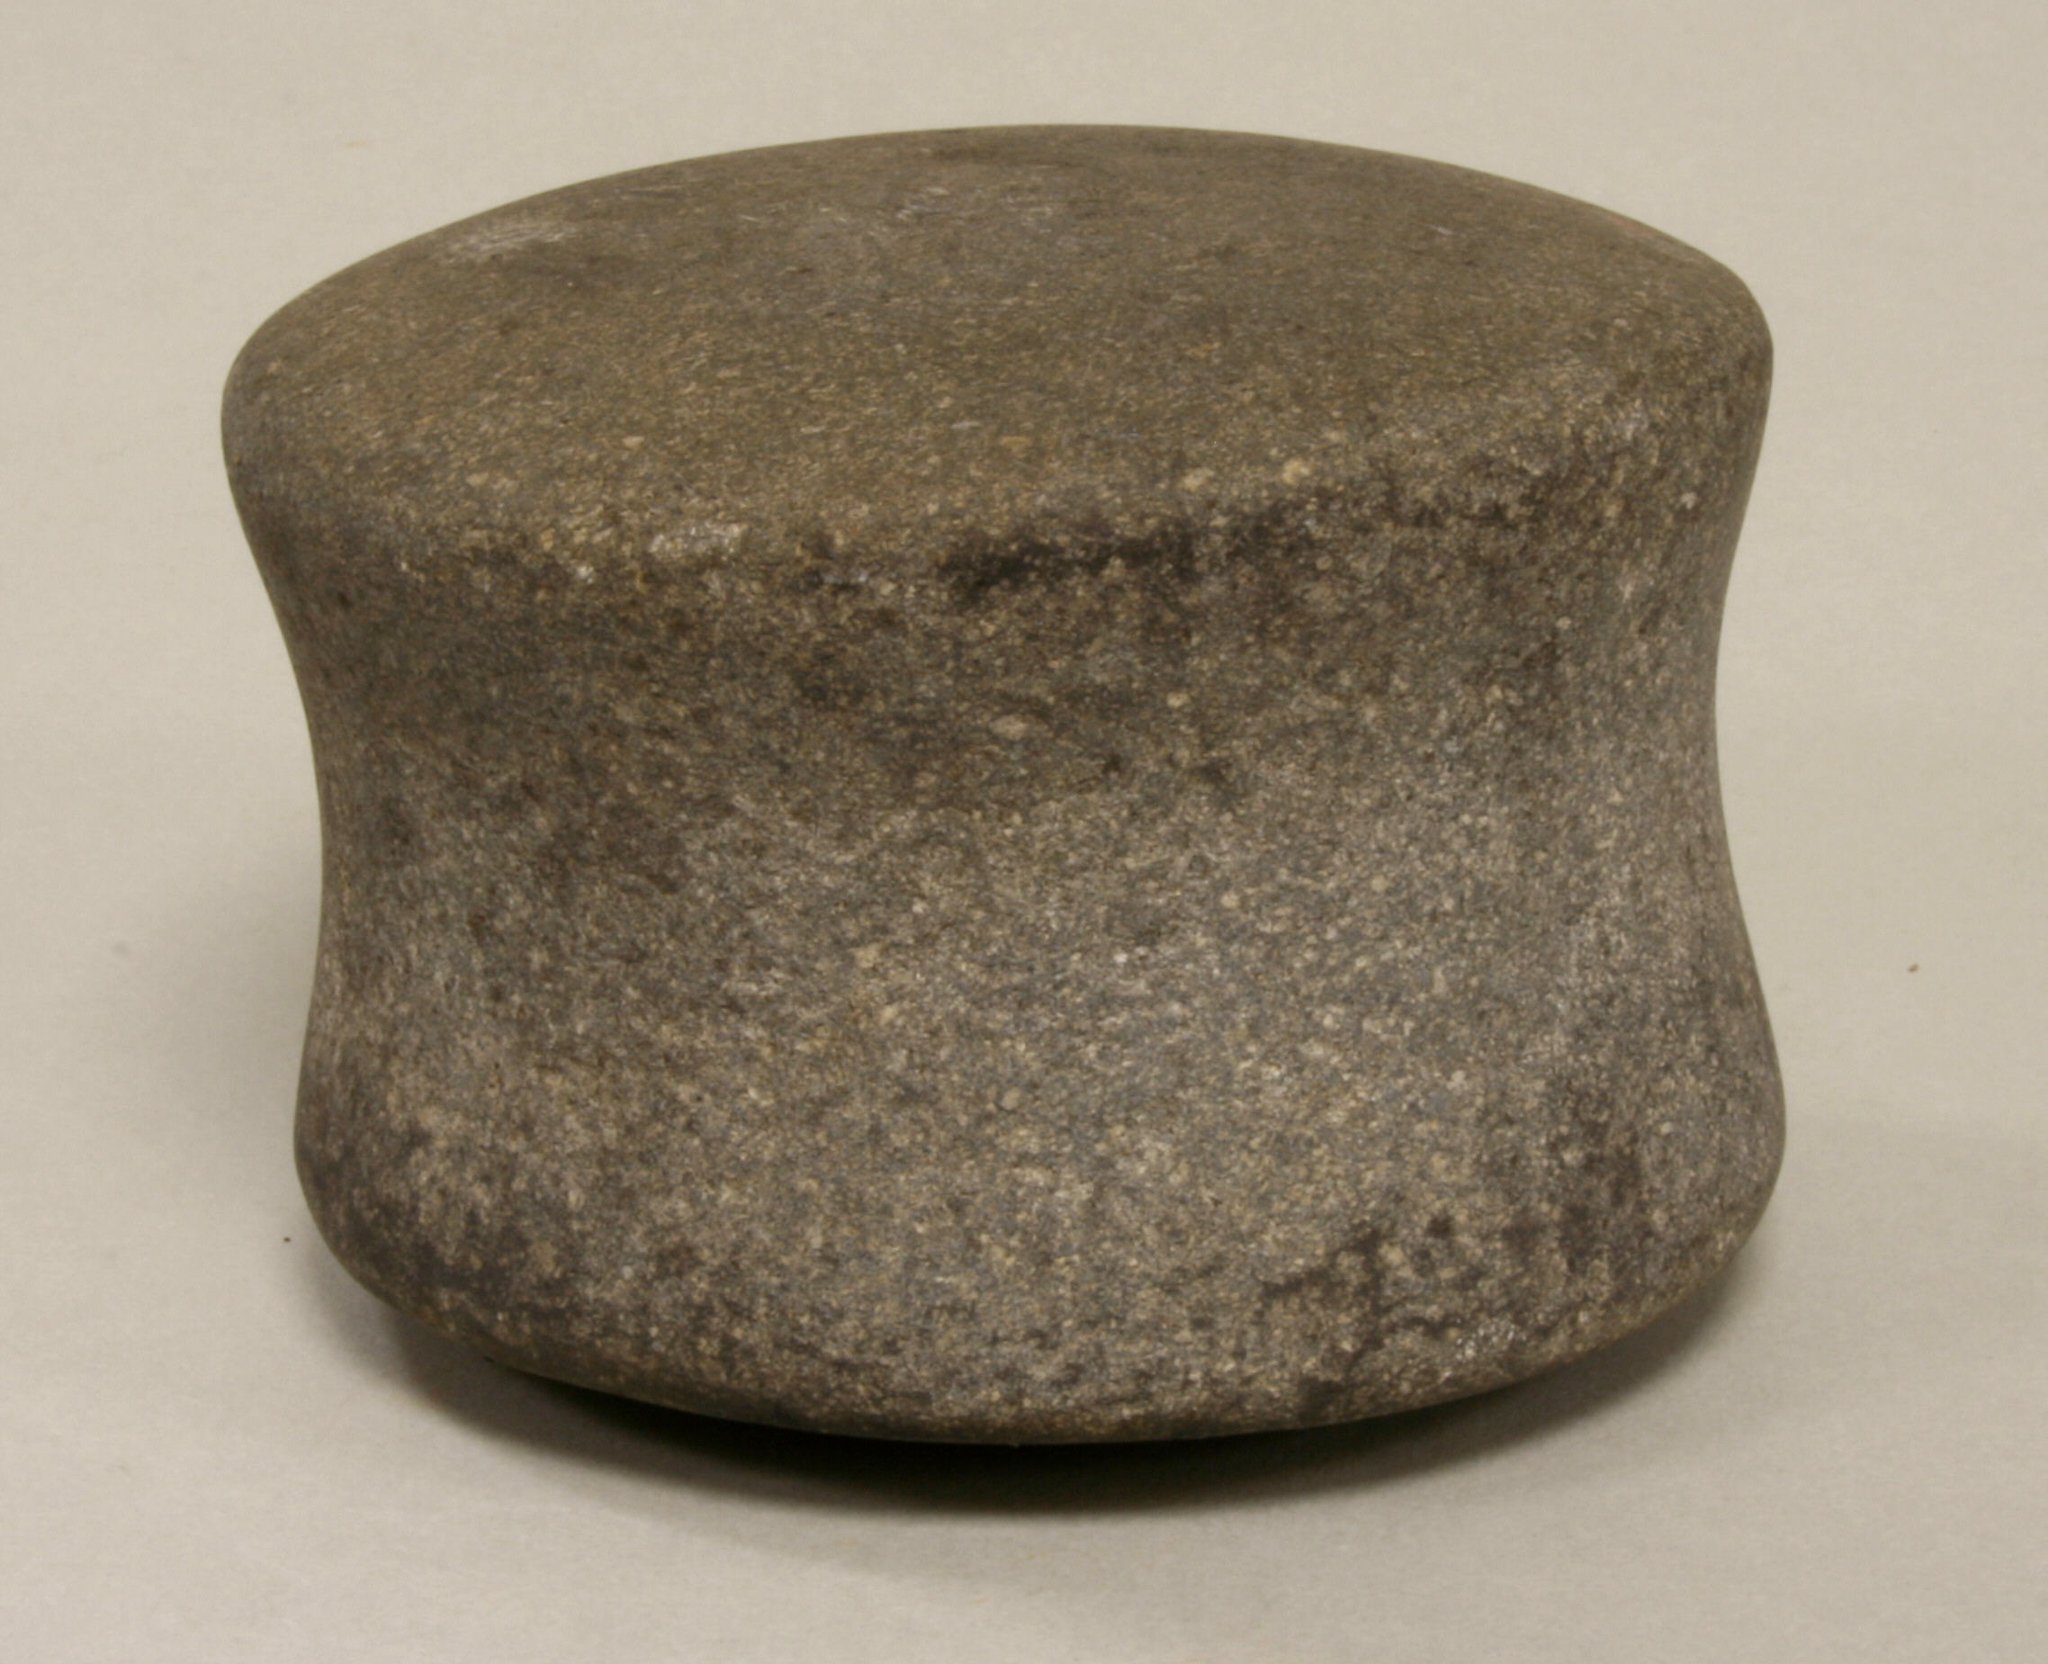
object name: pounder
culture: mexican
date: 1501-1600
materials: stone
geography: mexico